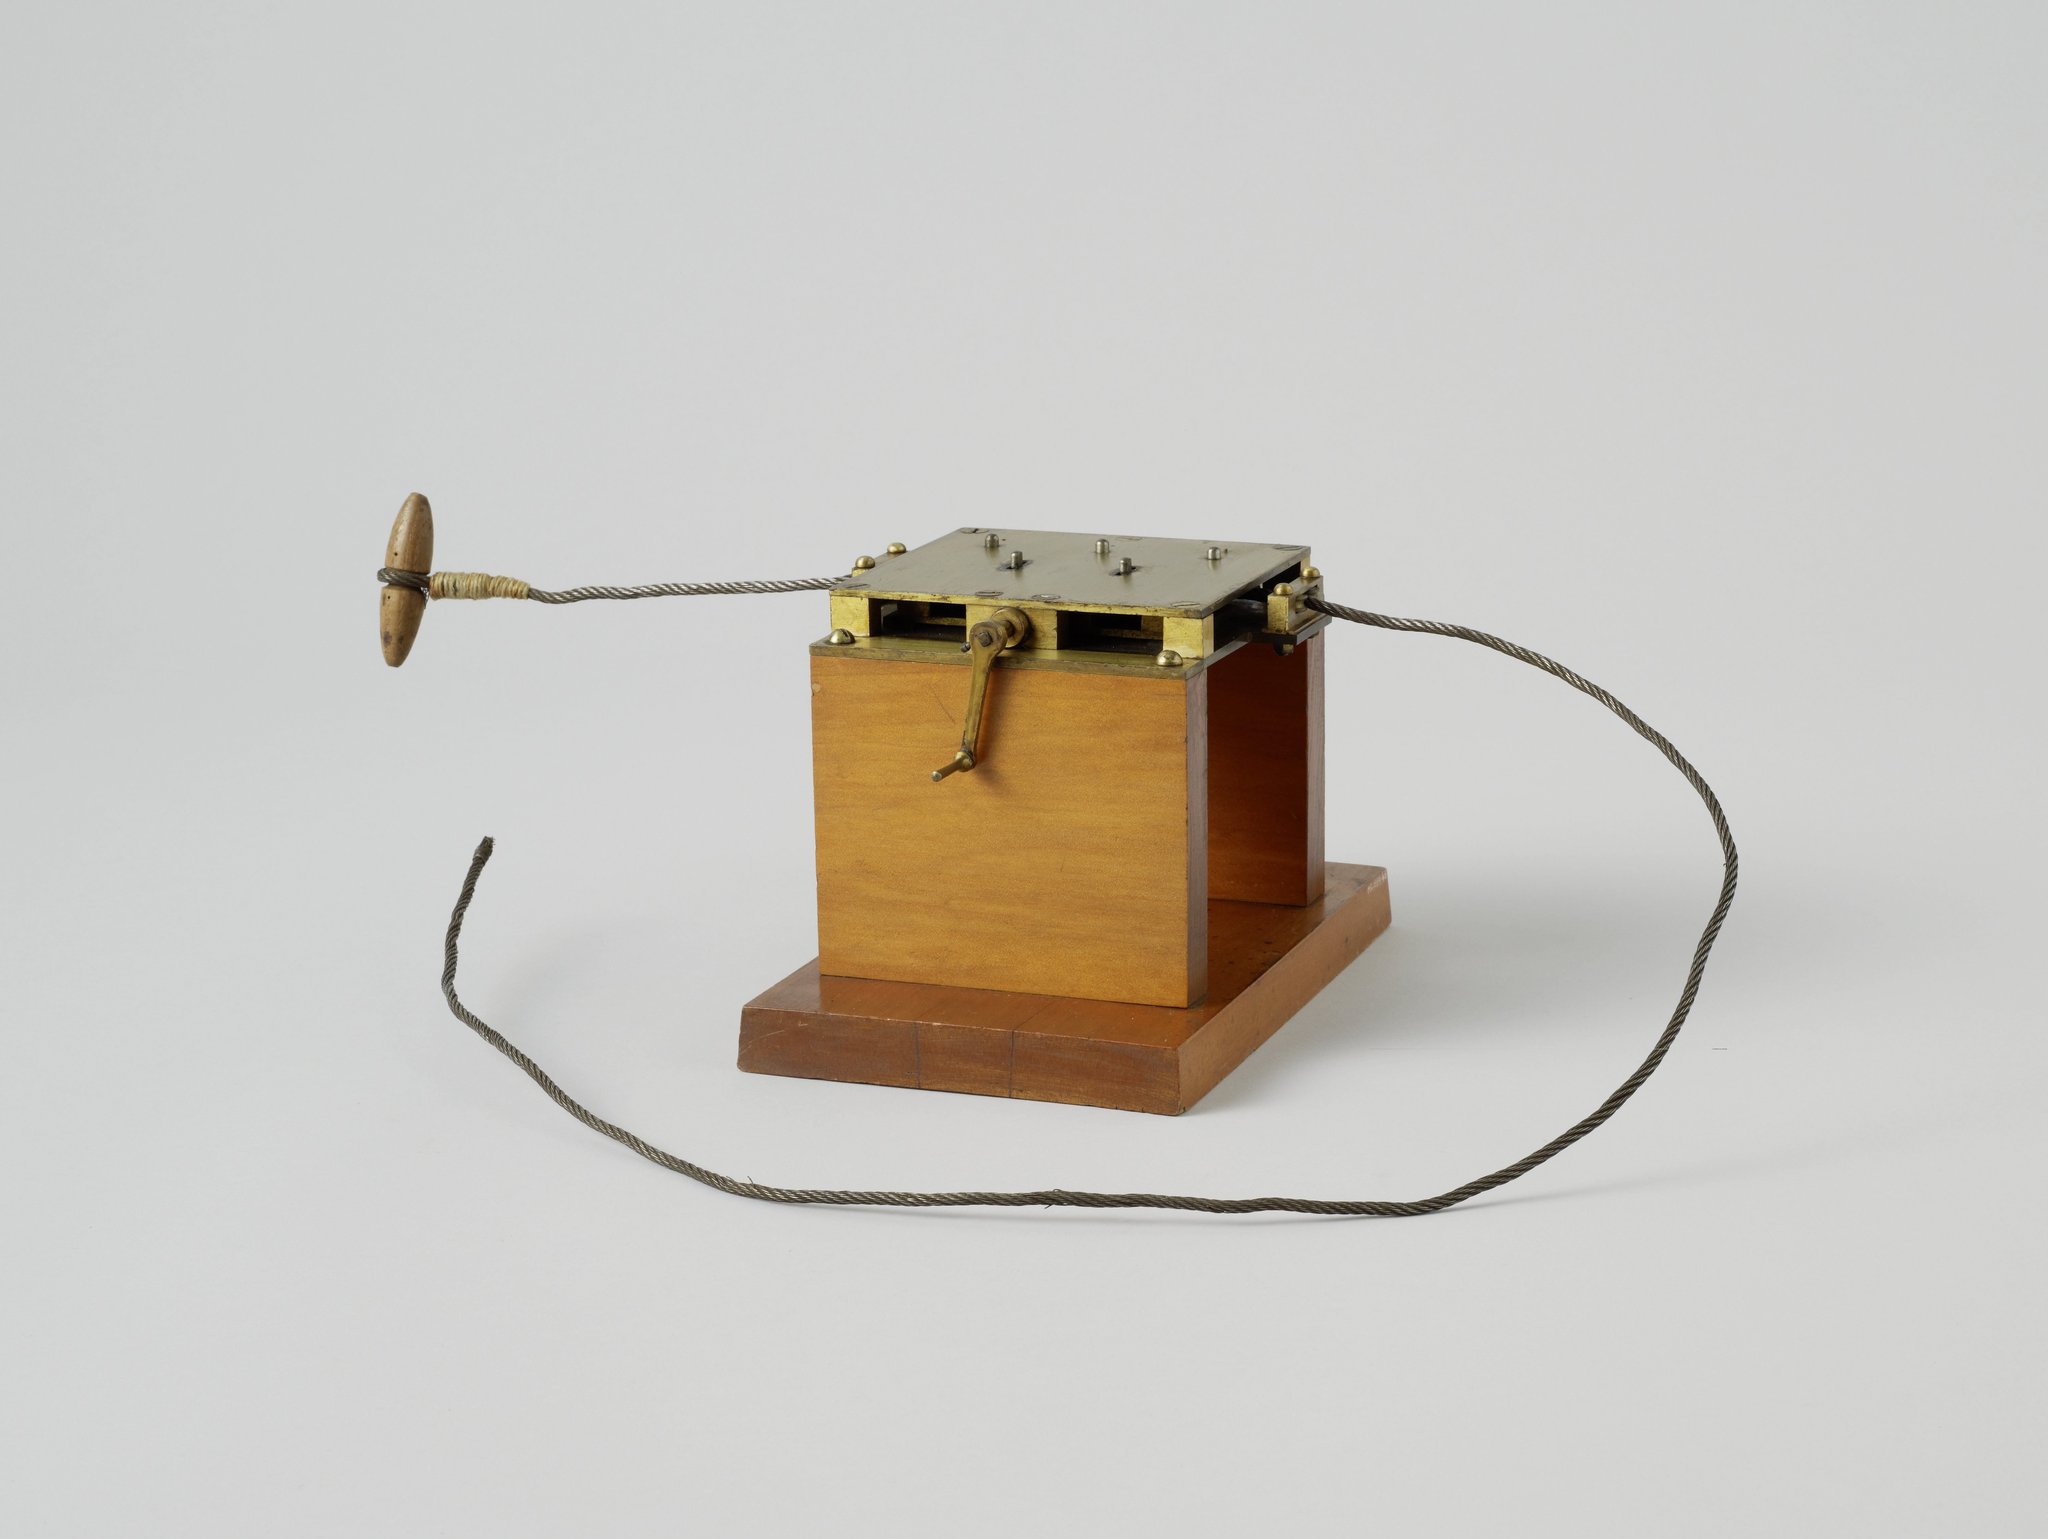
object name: demonstration model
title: Model of Cable Stopper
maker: Anonymous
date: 1830-1870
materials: brass, iron, fiber, wood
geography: netherlands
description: Model van een onbekend apparaat, waarin een staalkabel tussen een rij van drie en een rij van twee schijven wordt geklemd. De rijen van schijven worden door middel van een kruk tegen elkaar gedrukt. De kabel heeft een hart van hennep en aan een kant een klein handvat om aan te trekken.